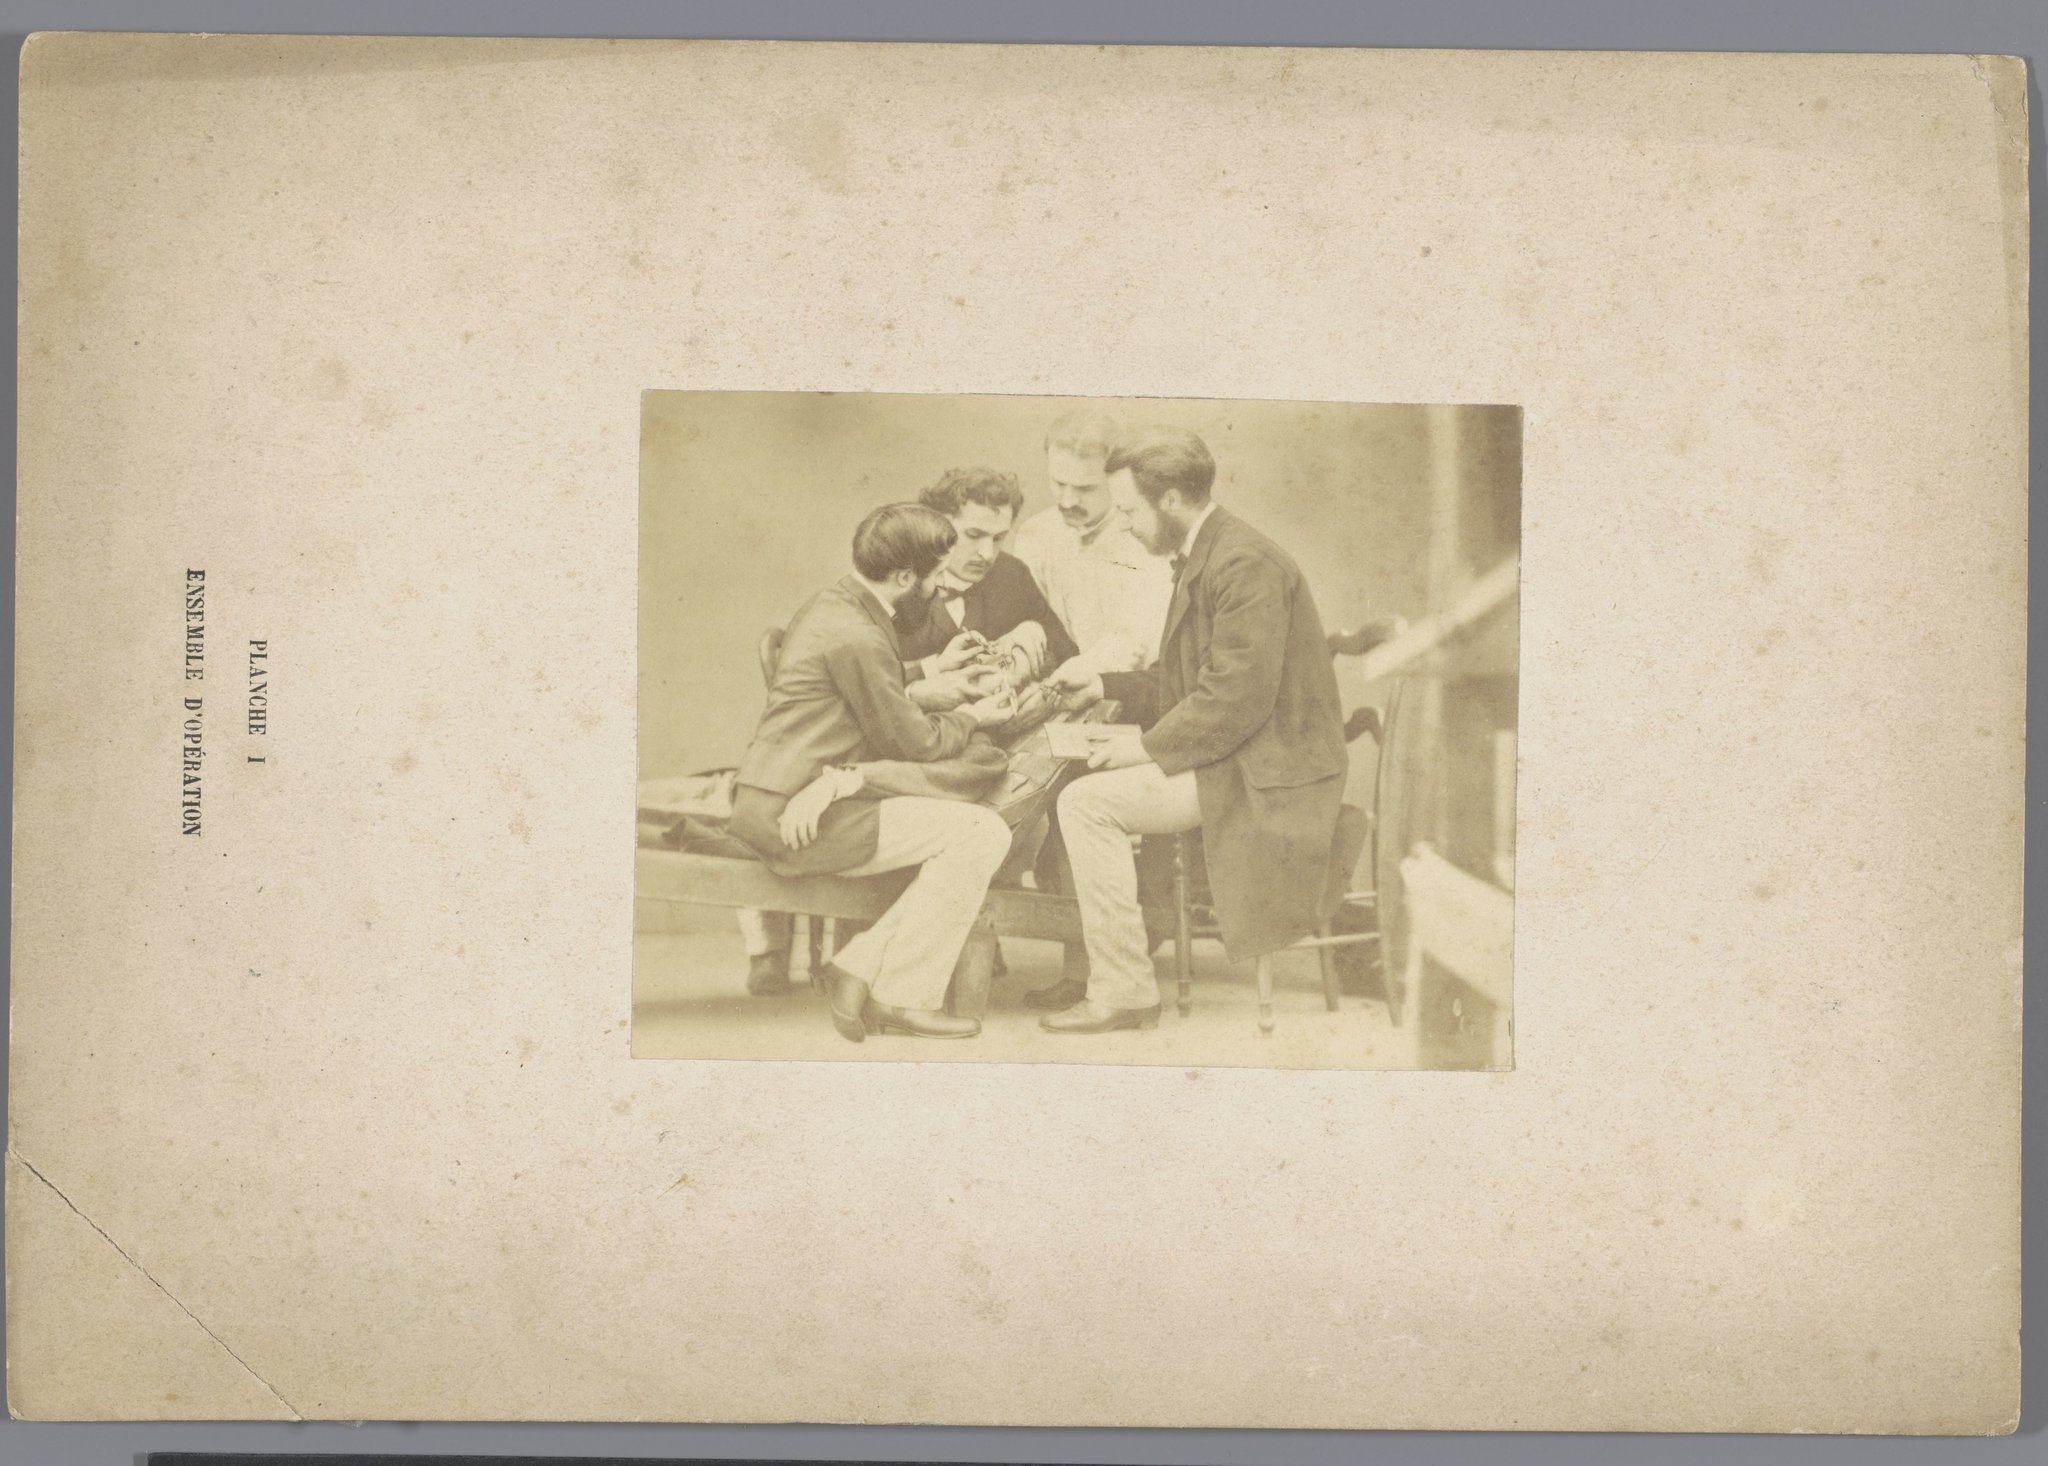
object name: page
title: Ensemble d'opération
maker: a. de montméja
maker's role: arts, fotograaf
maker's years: 1841-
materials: photographic support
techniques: albumen print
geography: france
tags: barber; surgeon, operation, surgery, disabilities affecting the eyes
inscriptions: number: ‘Planche I’